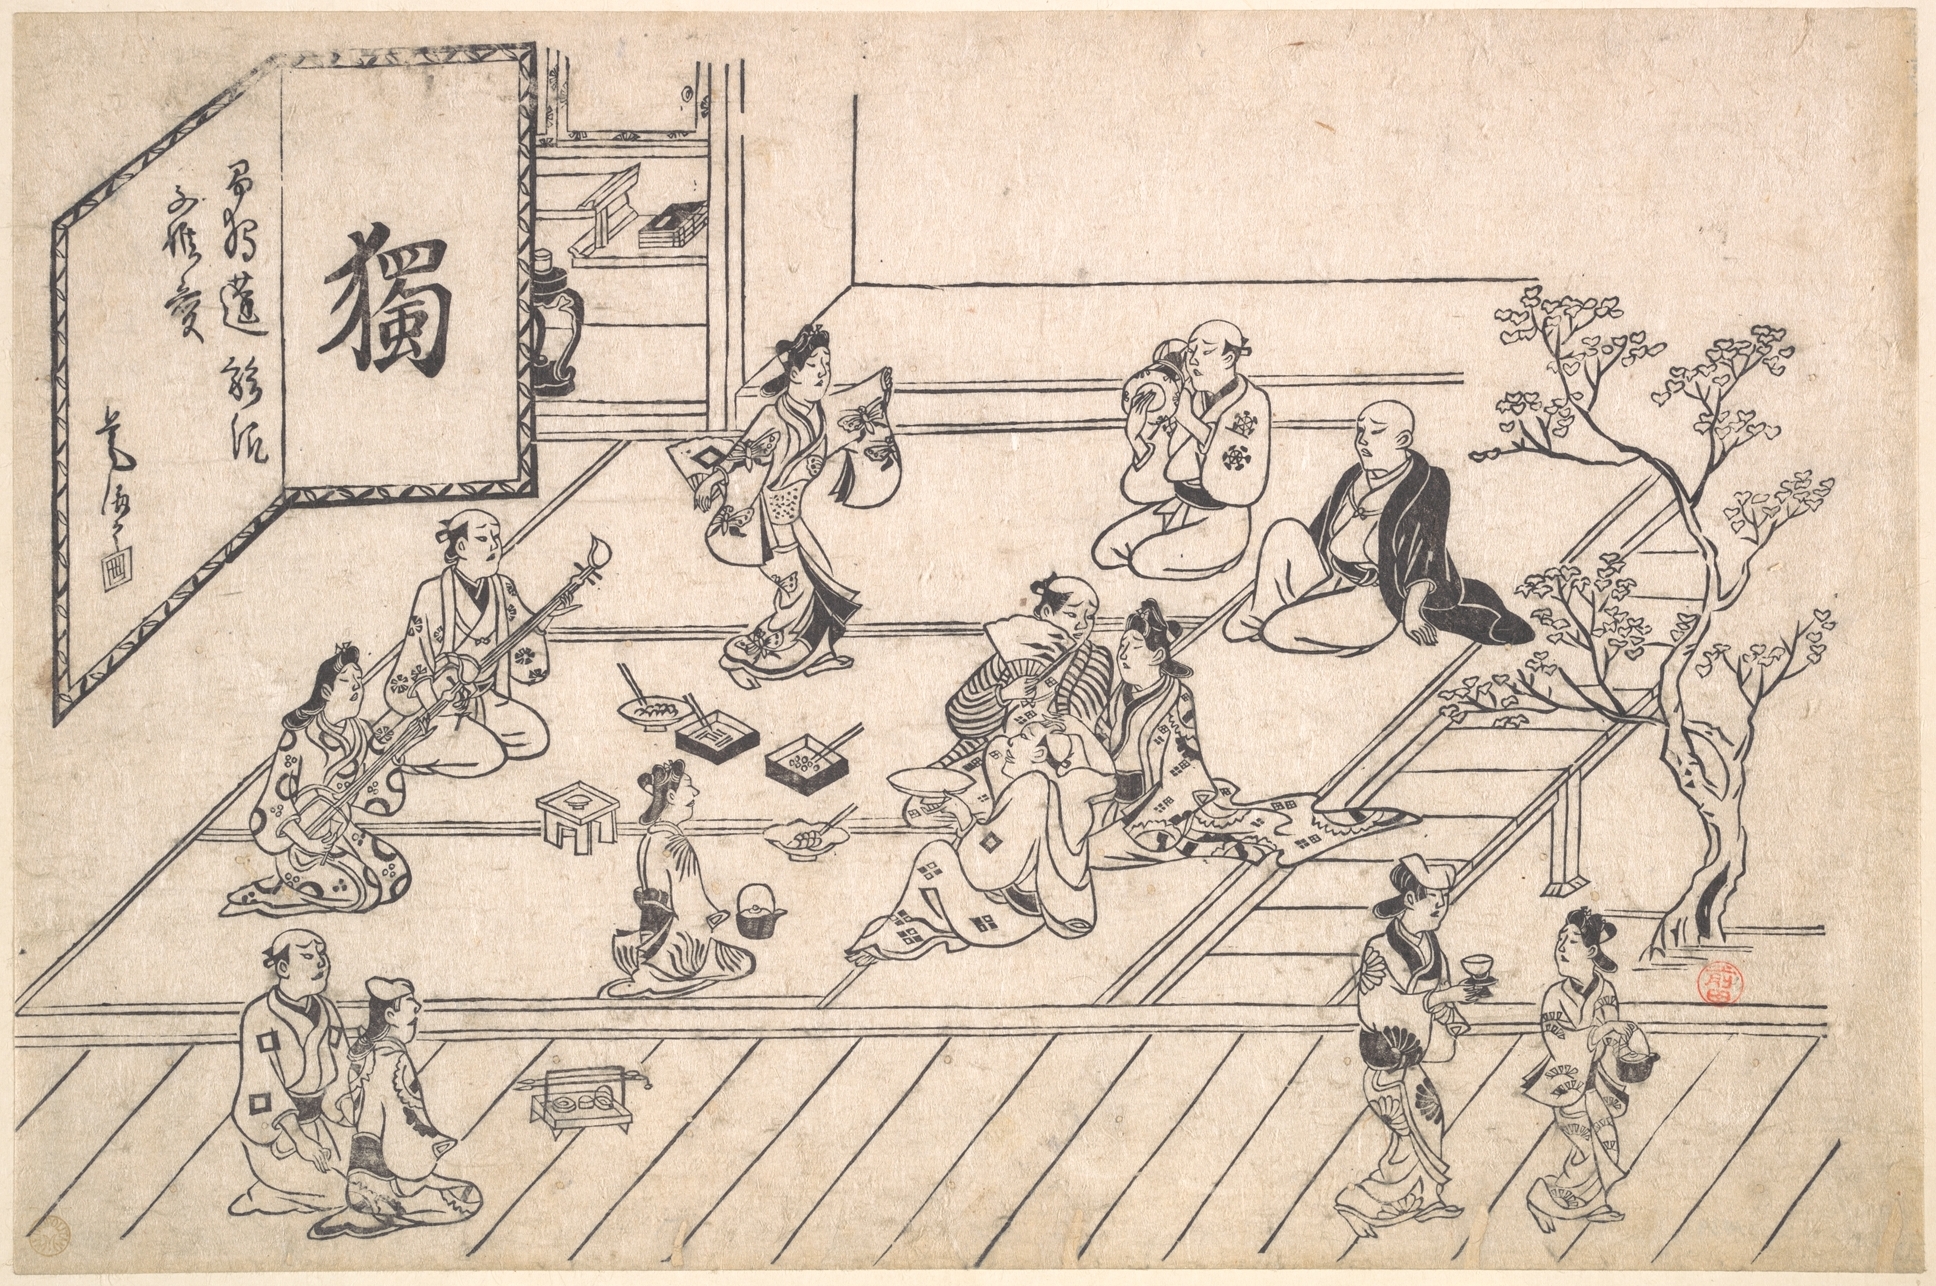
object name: print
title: Interior Scene in the Yoshiwara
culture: japanese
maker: hishikawa moronobu 菱川師宣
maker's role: artist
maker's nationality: japanese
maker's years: 1618-1694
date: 1680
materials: ink, paper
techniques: woodblock print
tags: food,interiors,men,women,dancing,musicians